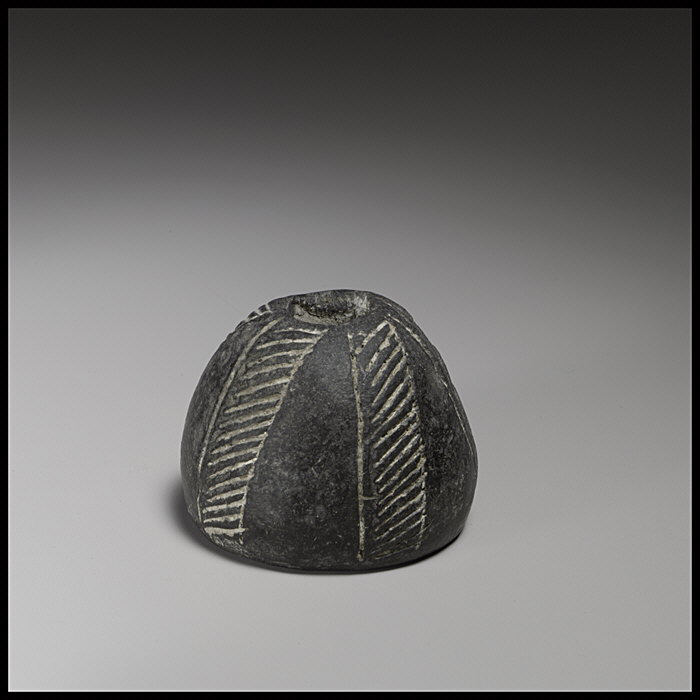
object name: spindle whorl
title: Terracotta conical-hemispherical spindle-whorl with flat base and rounded top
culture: cypriot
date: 1900-1725 BCE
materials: terracotta